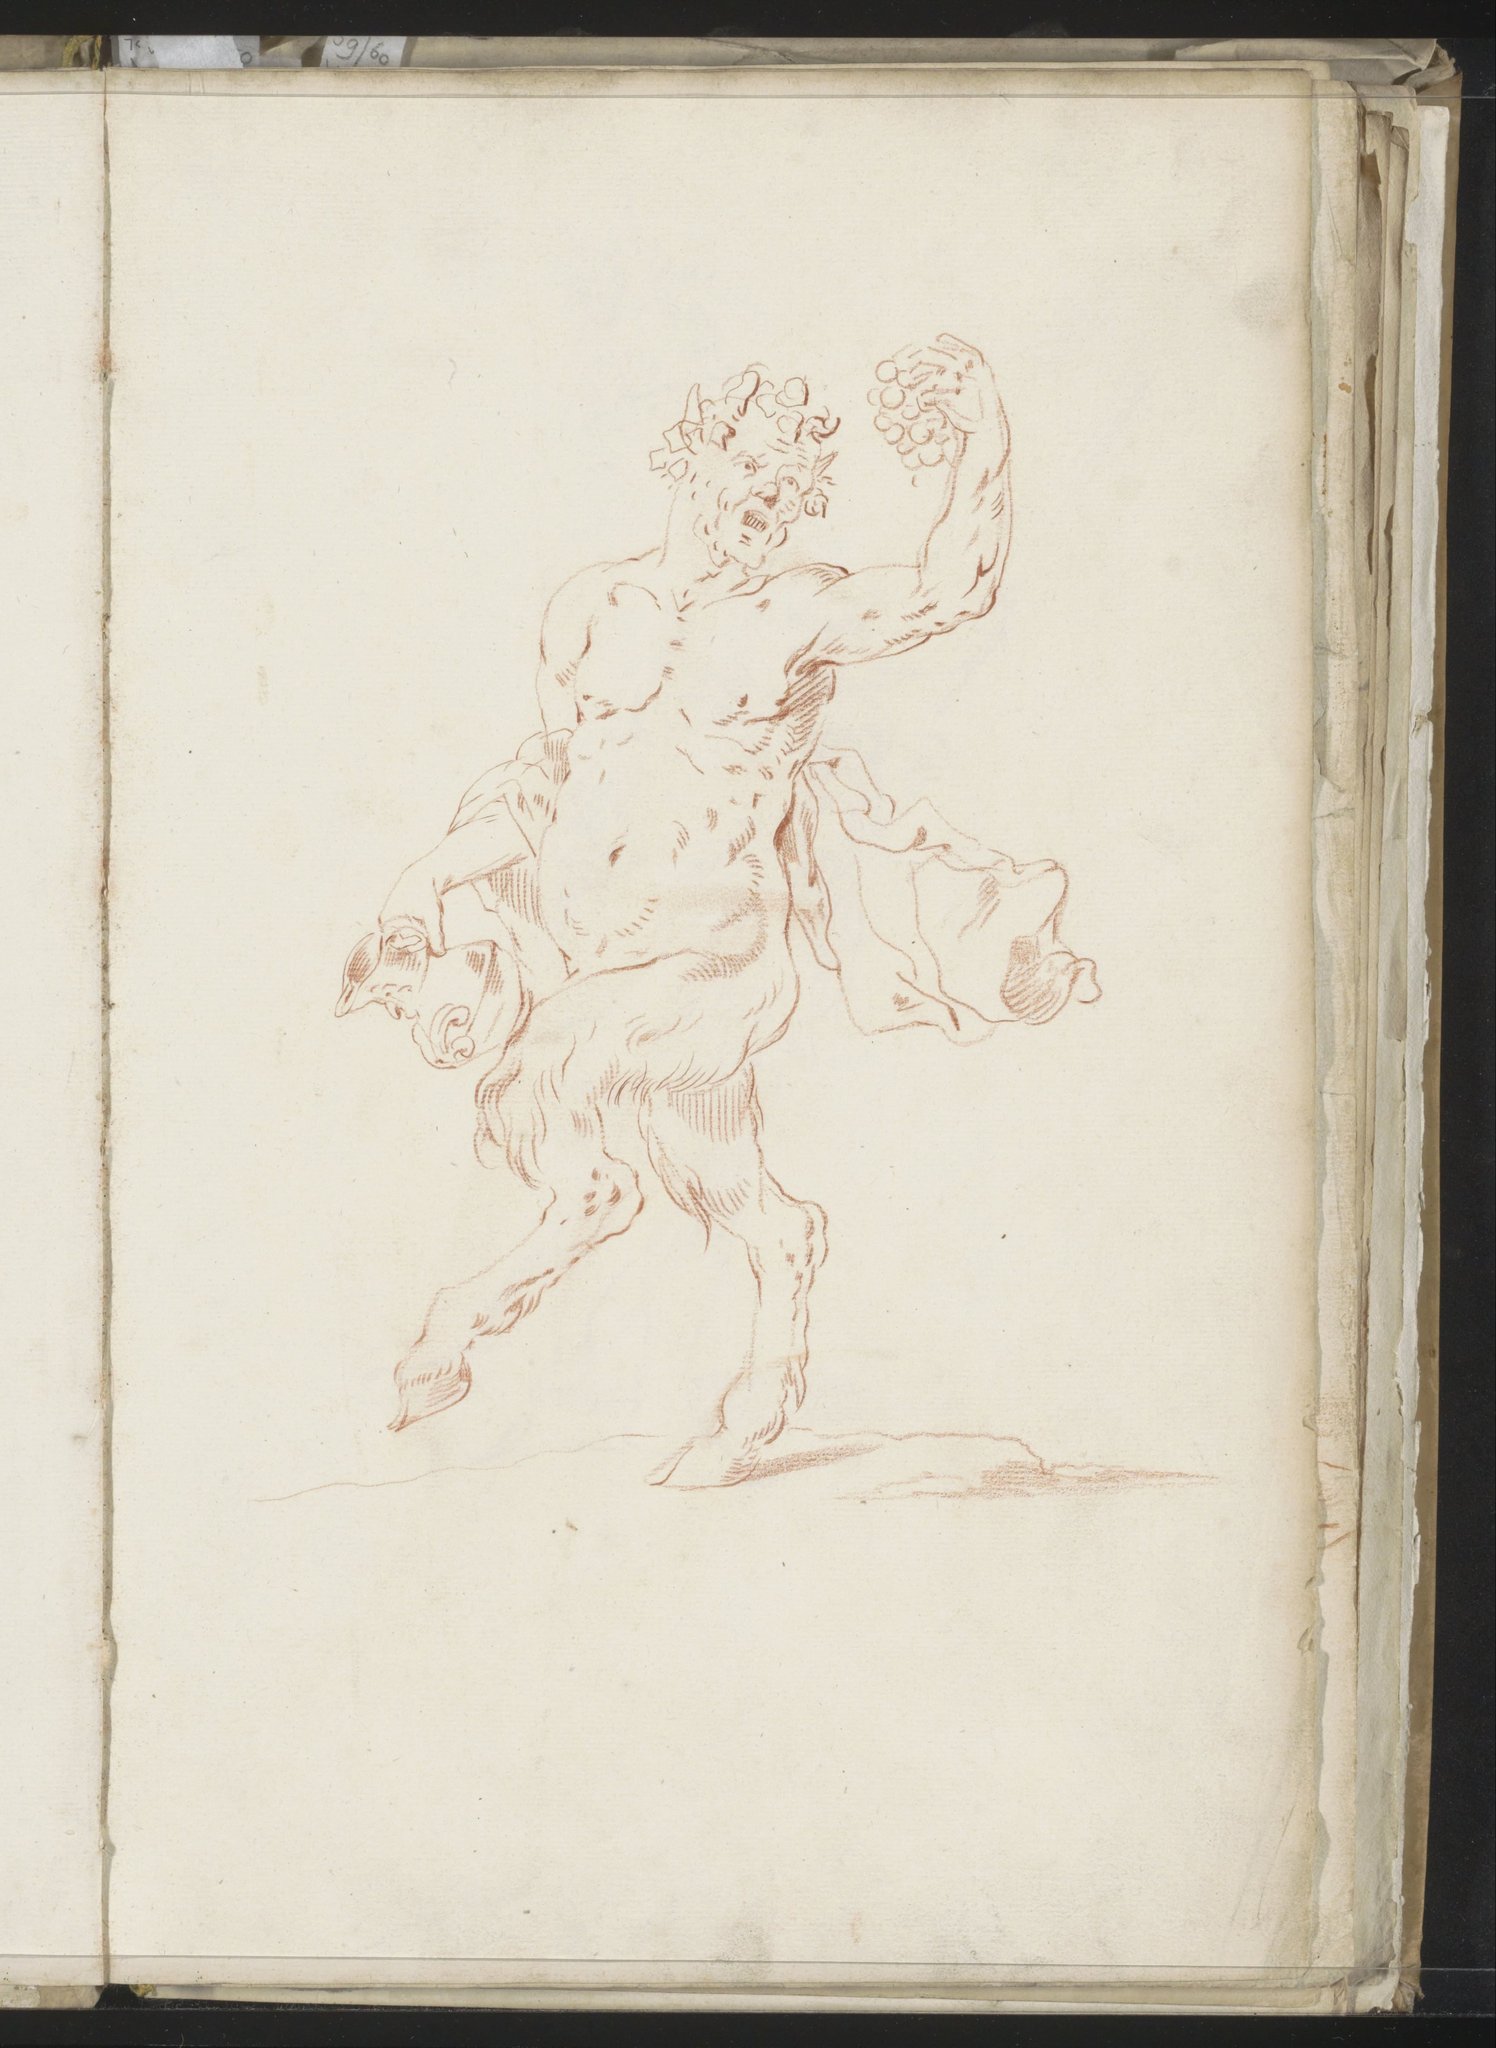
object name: sketchbook leaf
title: Sater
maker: jacob toorenvliet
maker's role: draughtsman, painter, print maker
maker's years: 1640-1719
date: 1701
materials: chalk, paper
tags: satyrs, fauns, sileni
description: Man met een menselijk torso en de poten, hoeven, een horens van een geit. De sater houdt een druiventros in de lucht en draagt in zijn andere hand een kan als verwijzing naar het dienaarschap van Dionysius. Blad 3 recto uit een schetsboek met 63 bladen.